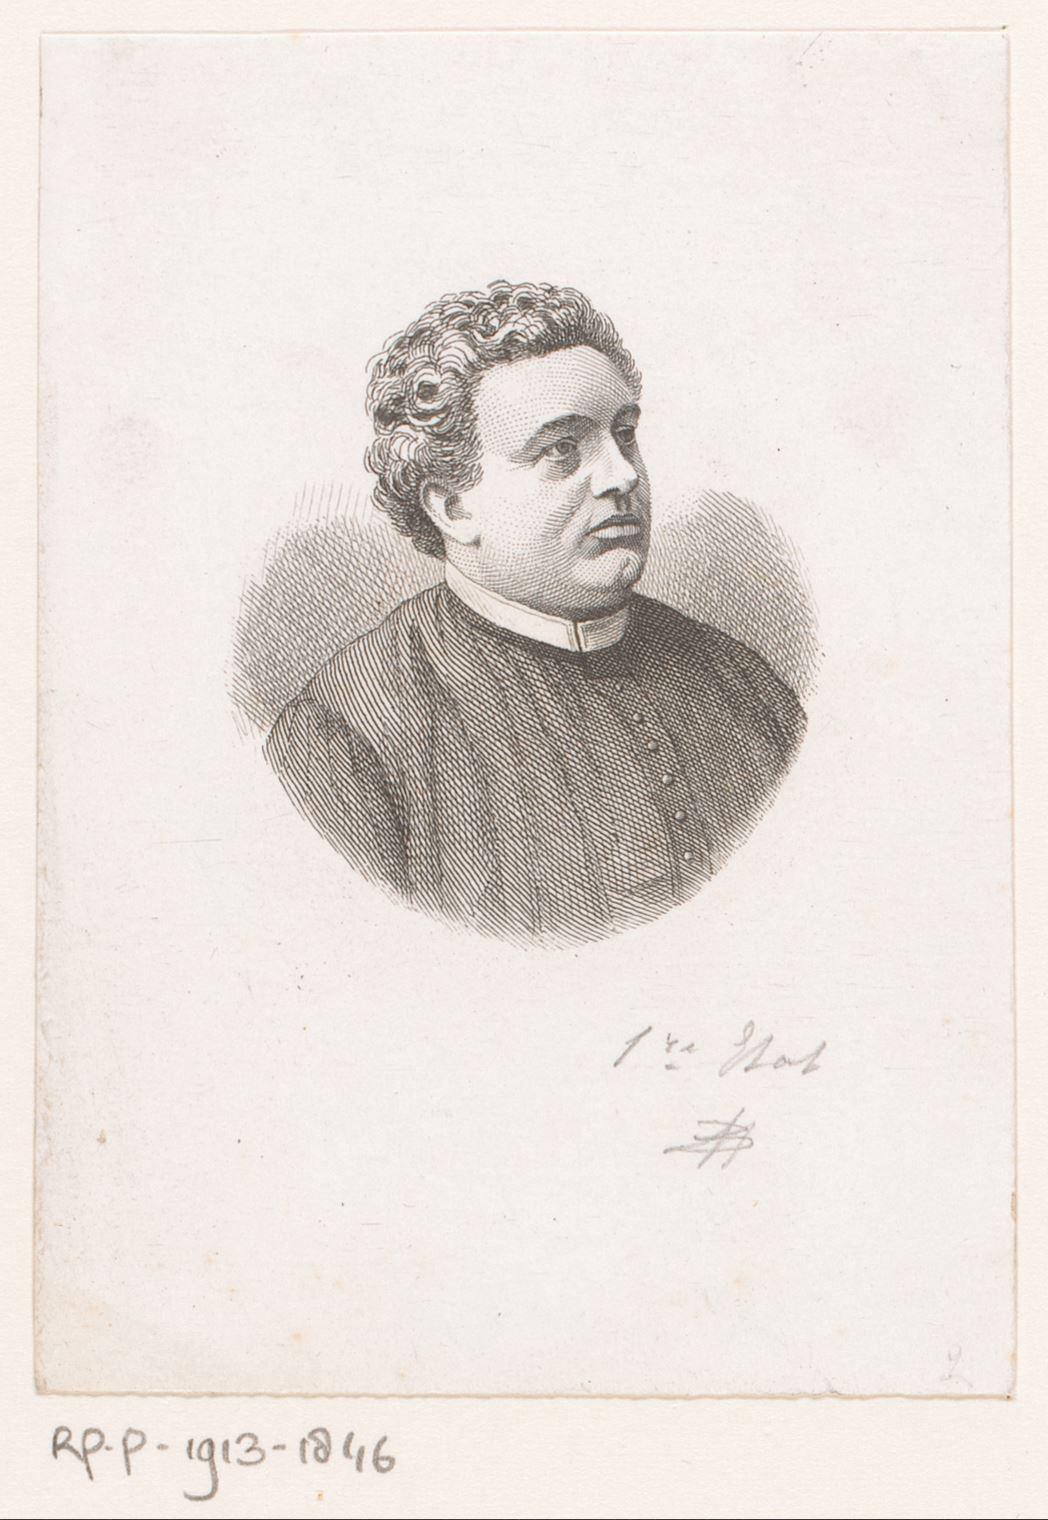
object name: print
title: Portret van een onbekende man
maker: jean baptiste pierre michiels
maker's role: print maker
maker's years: 1821-1890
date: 1831-1890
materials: paper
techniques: etching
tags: adult man, historical persons, organization, functionaries and dignitaries in roman catholic church; clergy in general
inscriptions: collector's mark: Lugt 2228, inscription: ‘1e Etat’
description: Aan de kleding is te zien dat de geportretteerde persoon waarschijnlijk een priester is.